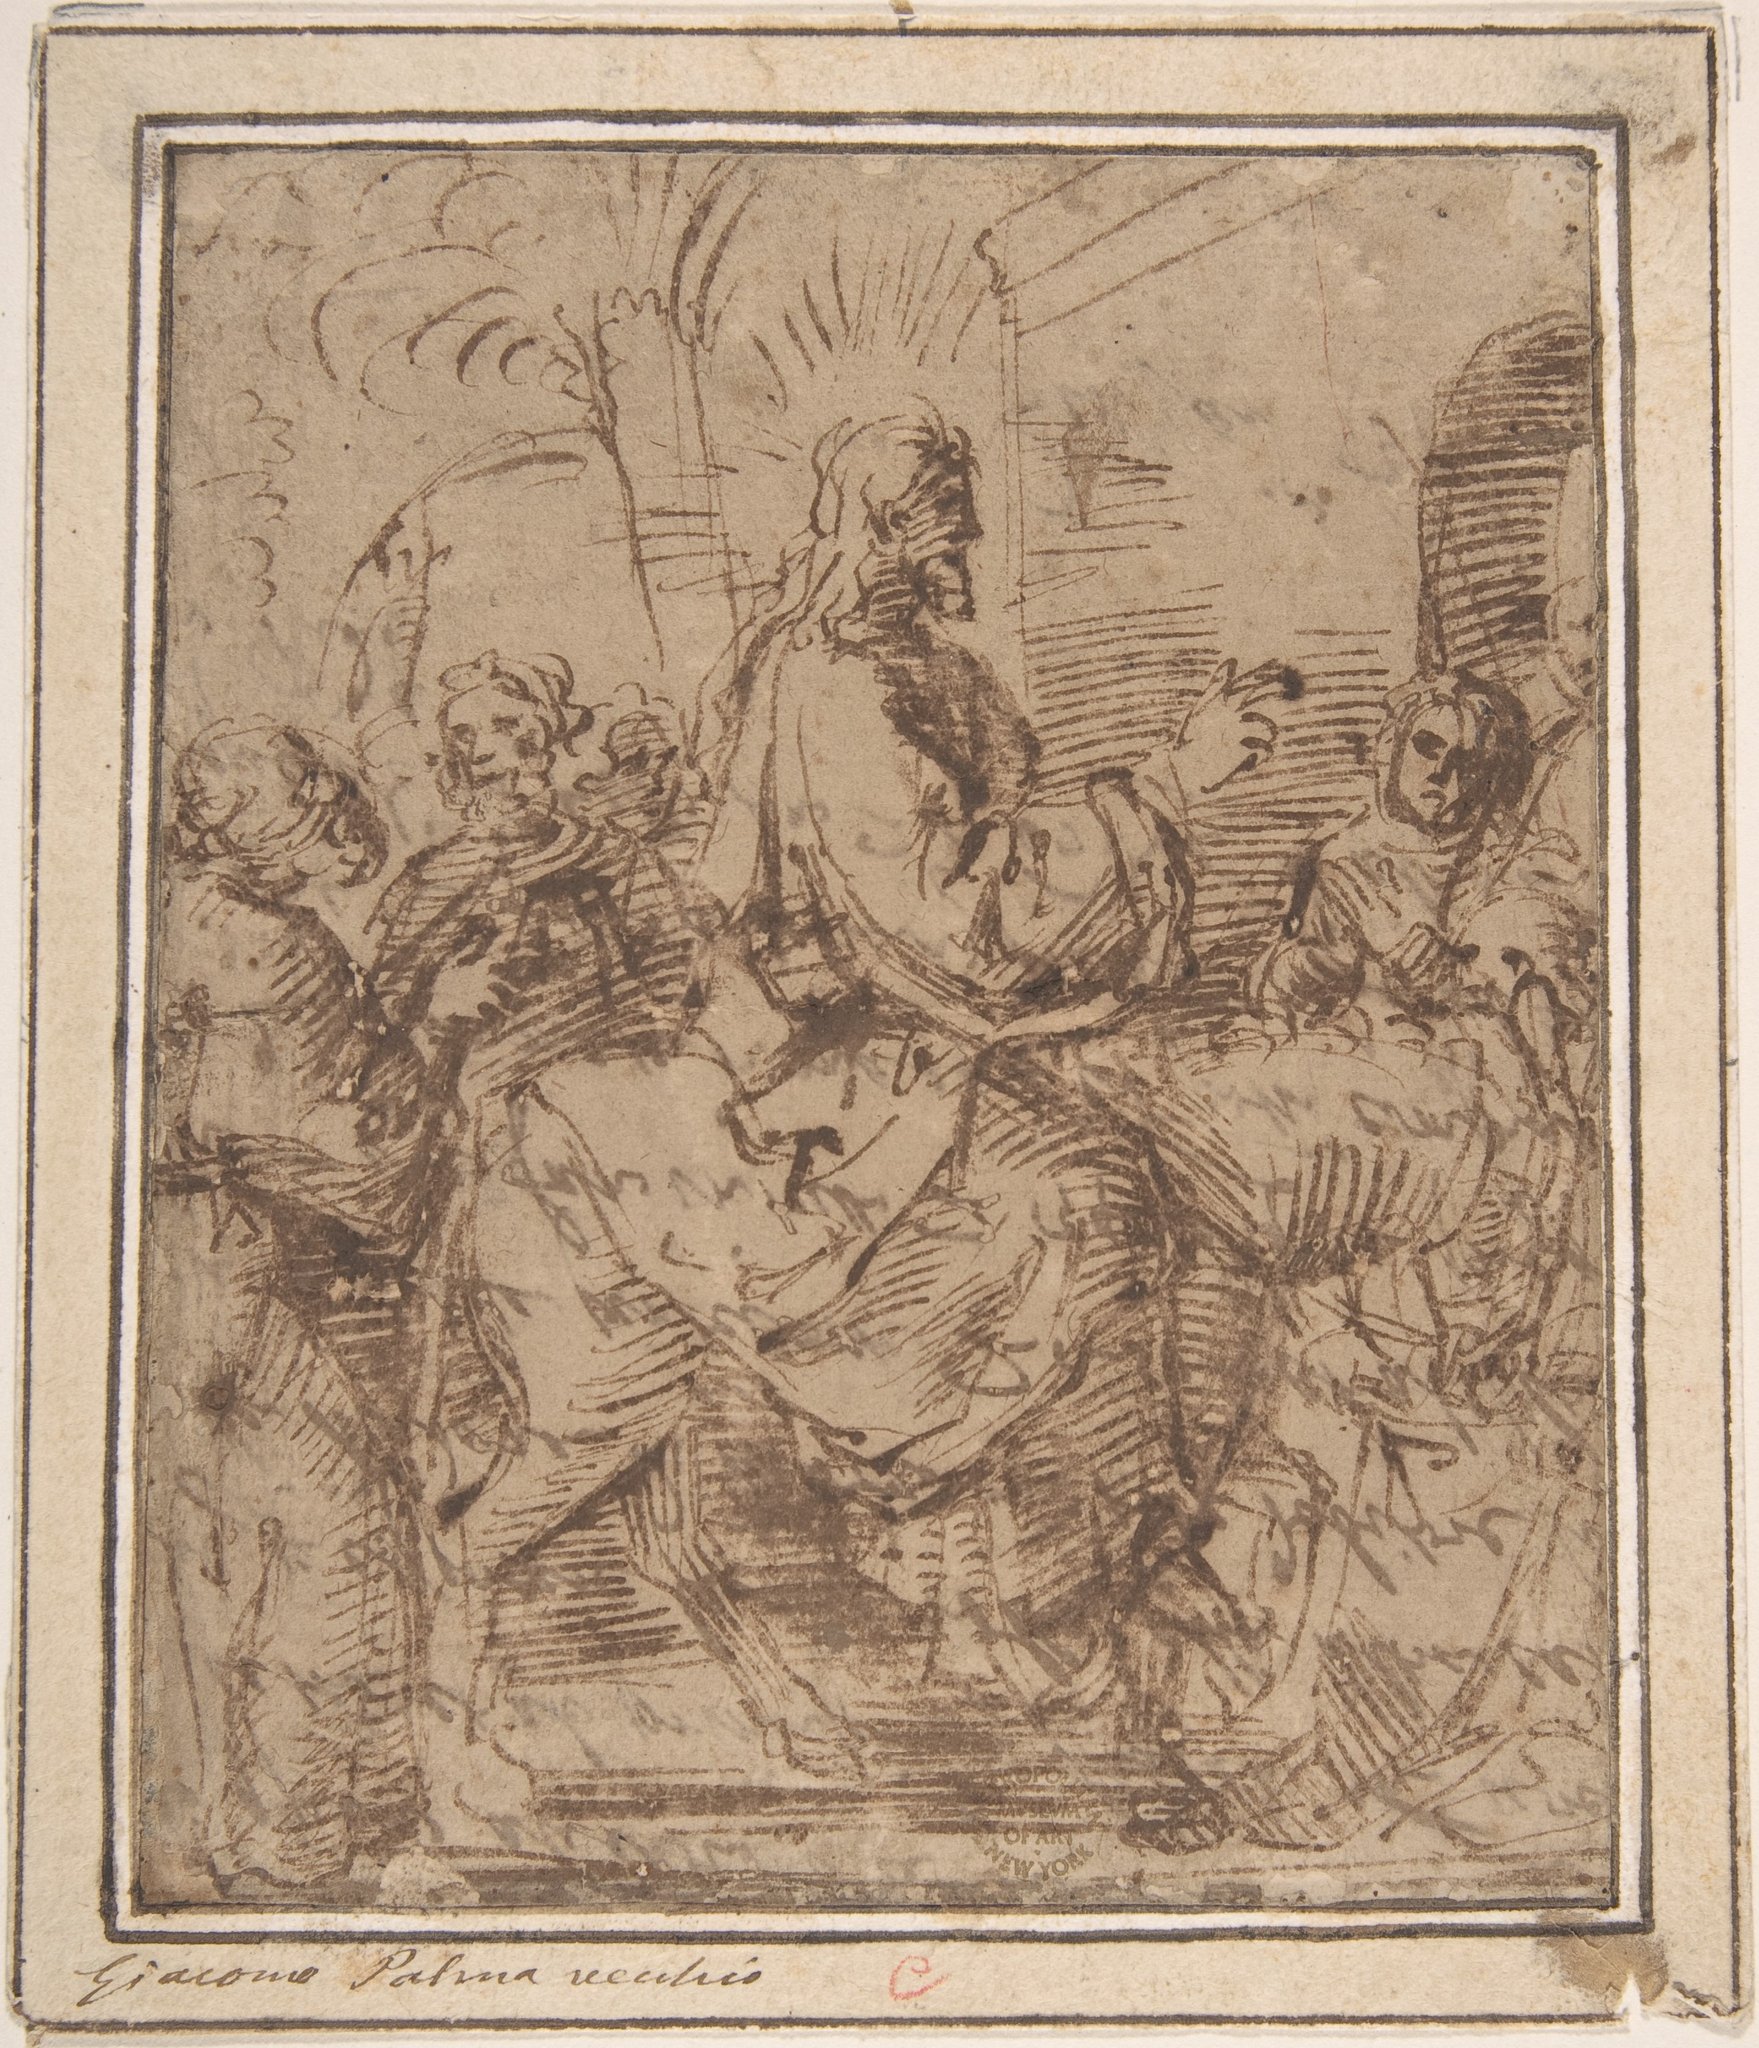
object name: drawing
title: Christ's Entry into Jerusalem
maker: anonymous, italian, venetian, 15th to 16th century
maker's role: artist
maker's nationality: italian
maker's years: 1400-1600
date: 1501-1600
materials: ink, paper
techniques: pen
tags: men,women,christ